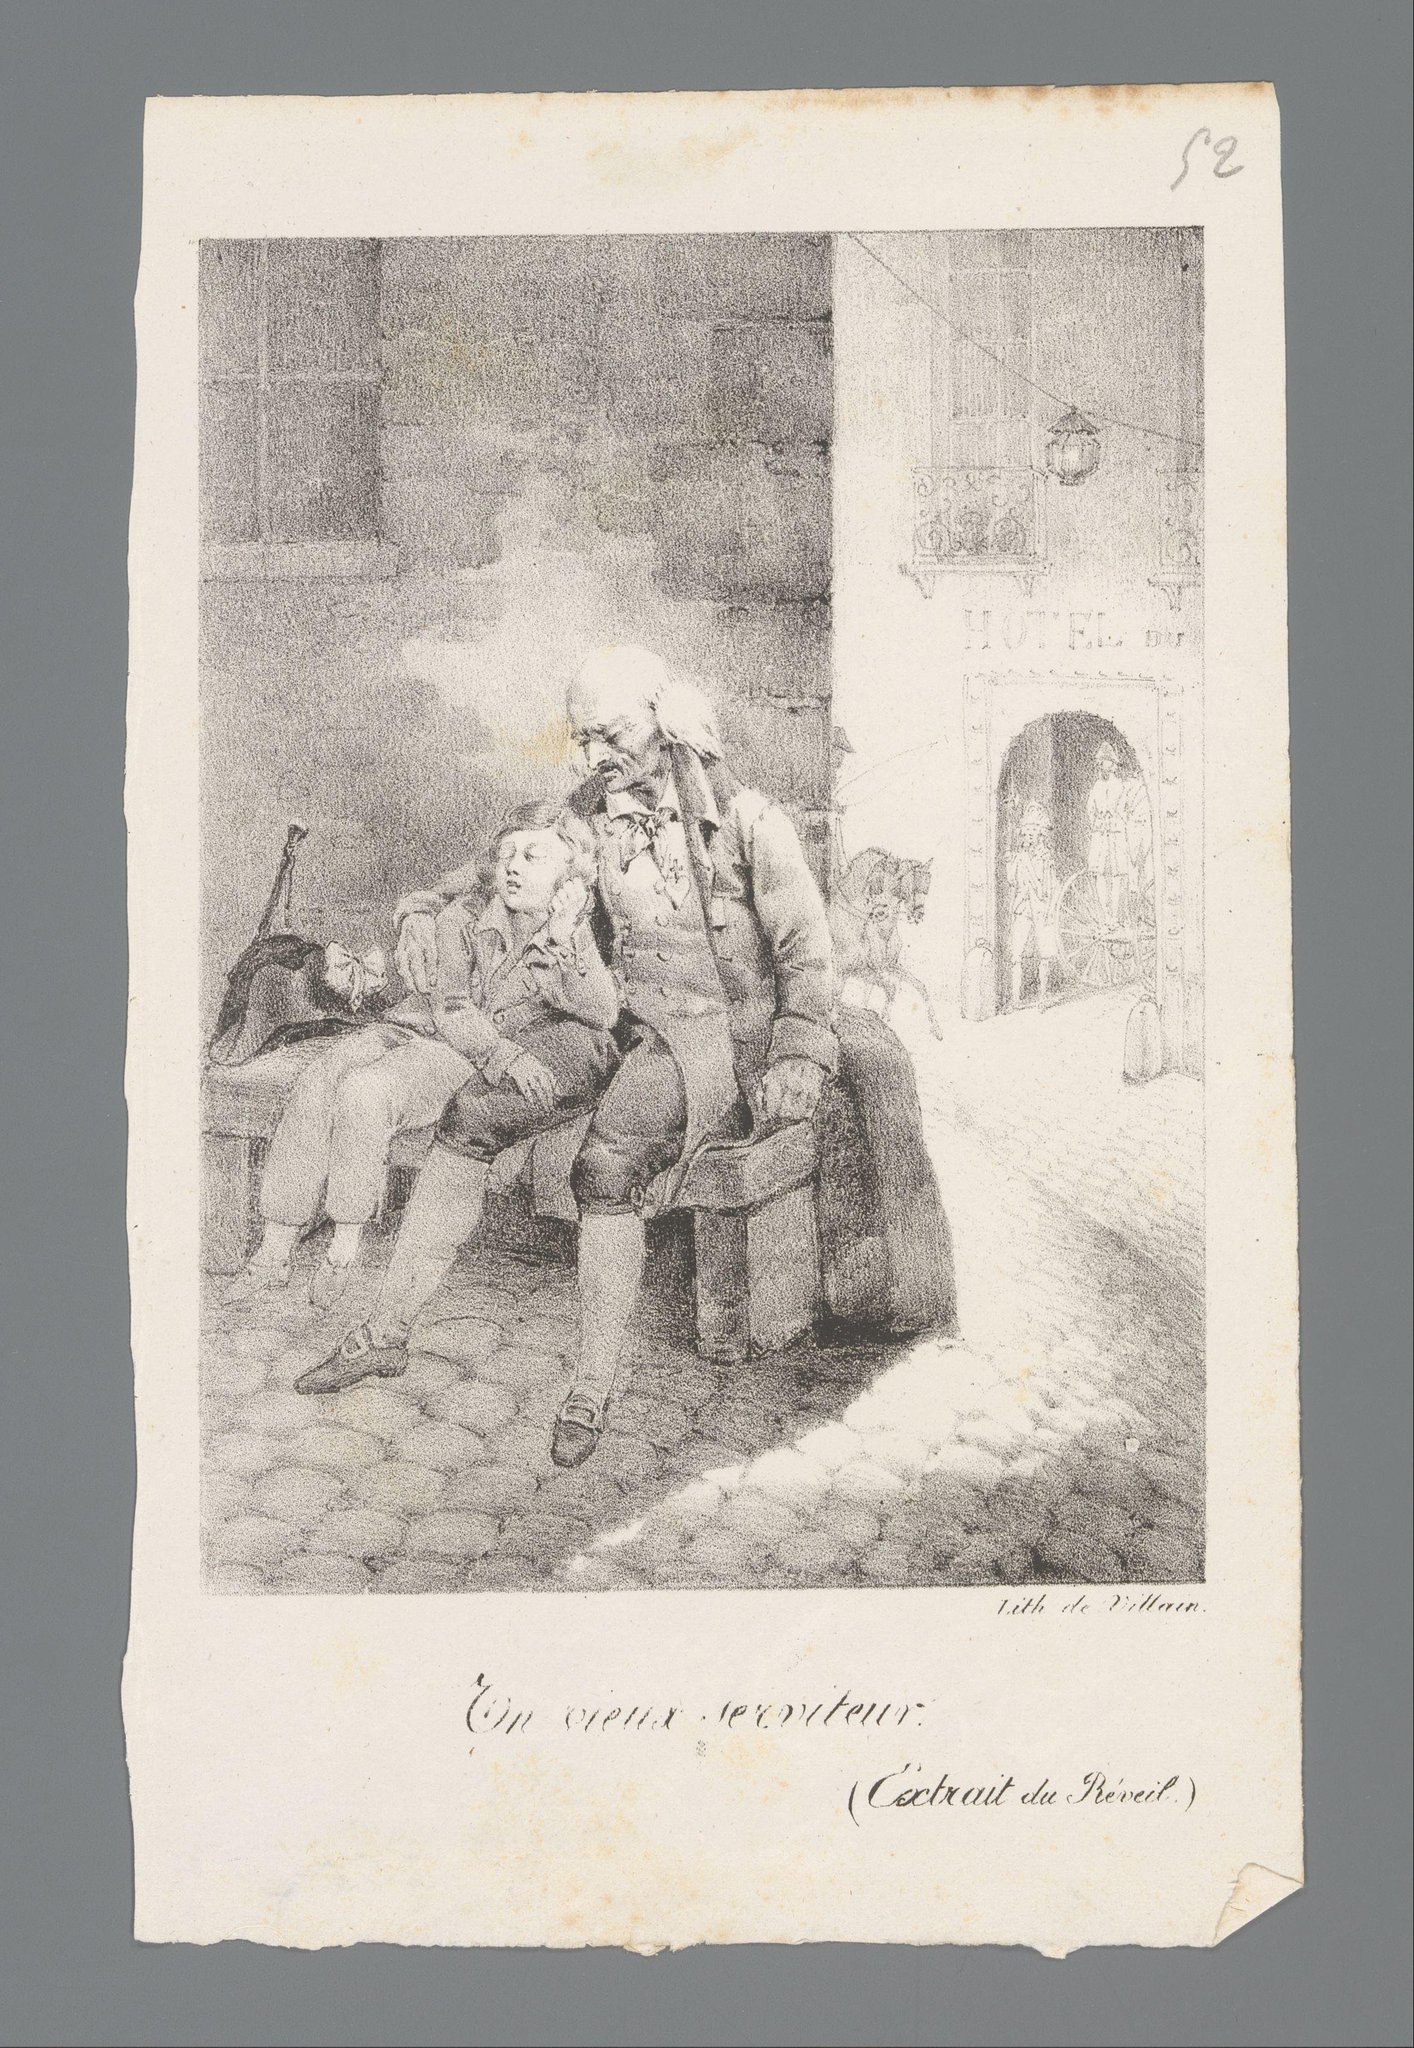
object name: print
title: Slapende jongen leunt tegen een oude man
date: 1822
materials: paper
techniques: lithograph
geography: paris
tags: child, old man, sleeping; unconsciousness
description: Prent uit: Le Réveil, journal des sciences, de la littérature, des moeurs, théâtres et beaux-arts (1822), nr. 145, 23 december 1822.